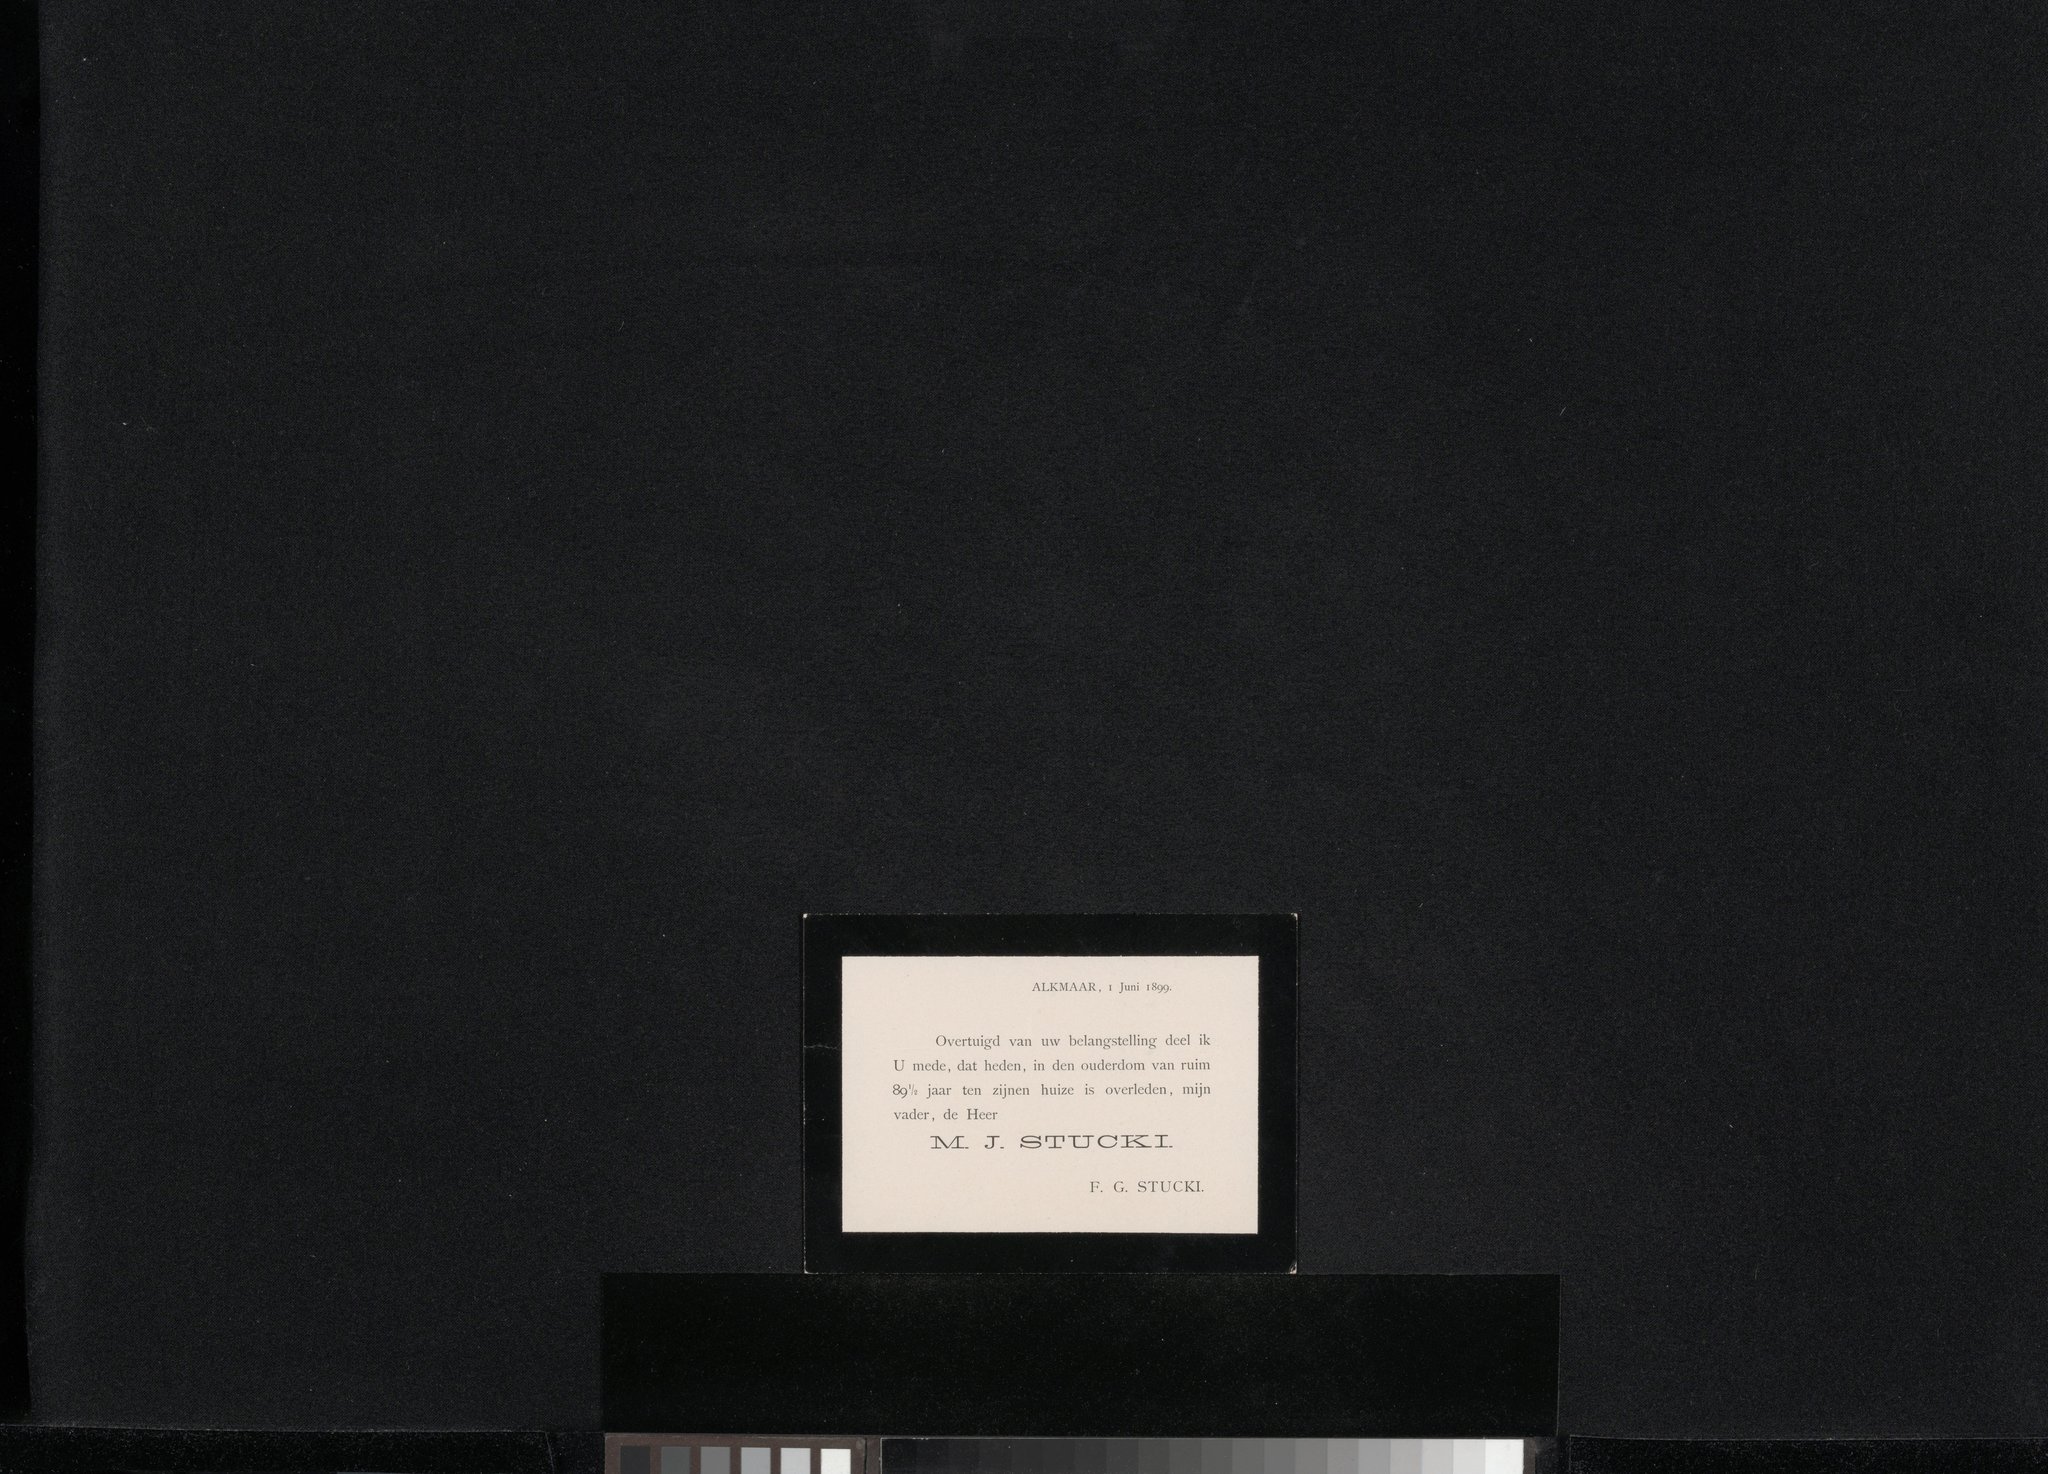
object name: overlijdensbericht, overlijdensadvertentie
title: Overlijdensbericht betreffende Marinus Jacobus Stucki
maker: Anonymous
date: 1899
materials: paper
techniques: printing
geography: alkmaar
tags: utrecht, draughtsman, marinus jacobus stucki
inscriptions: collector's mark: ‘RPK’